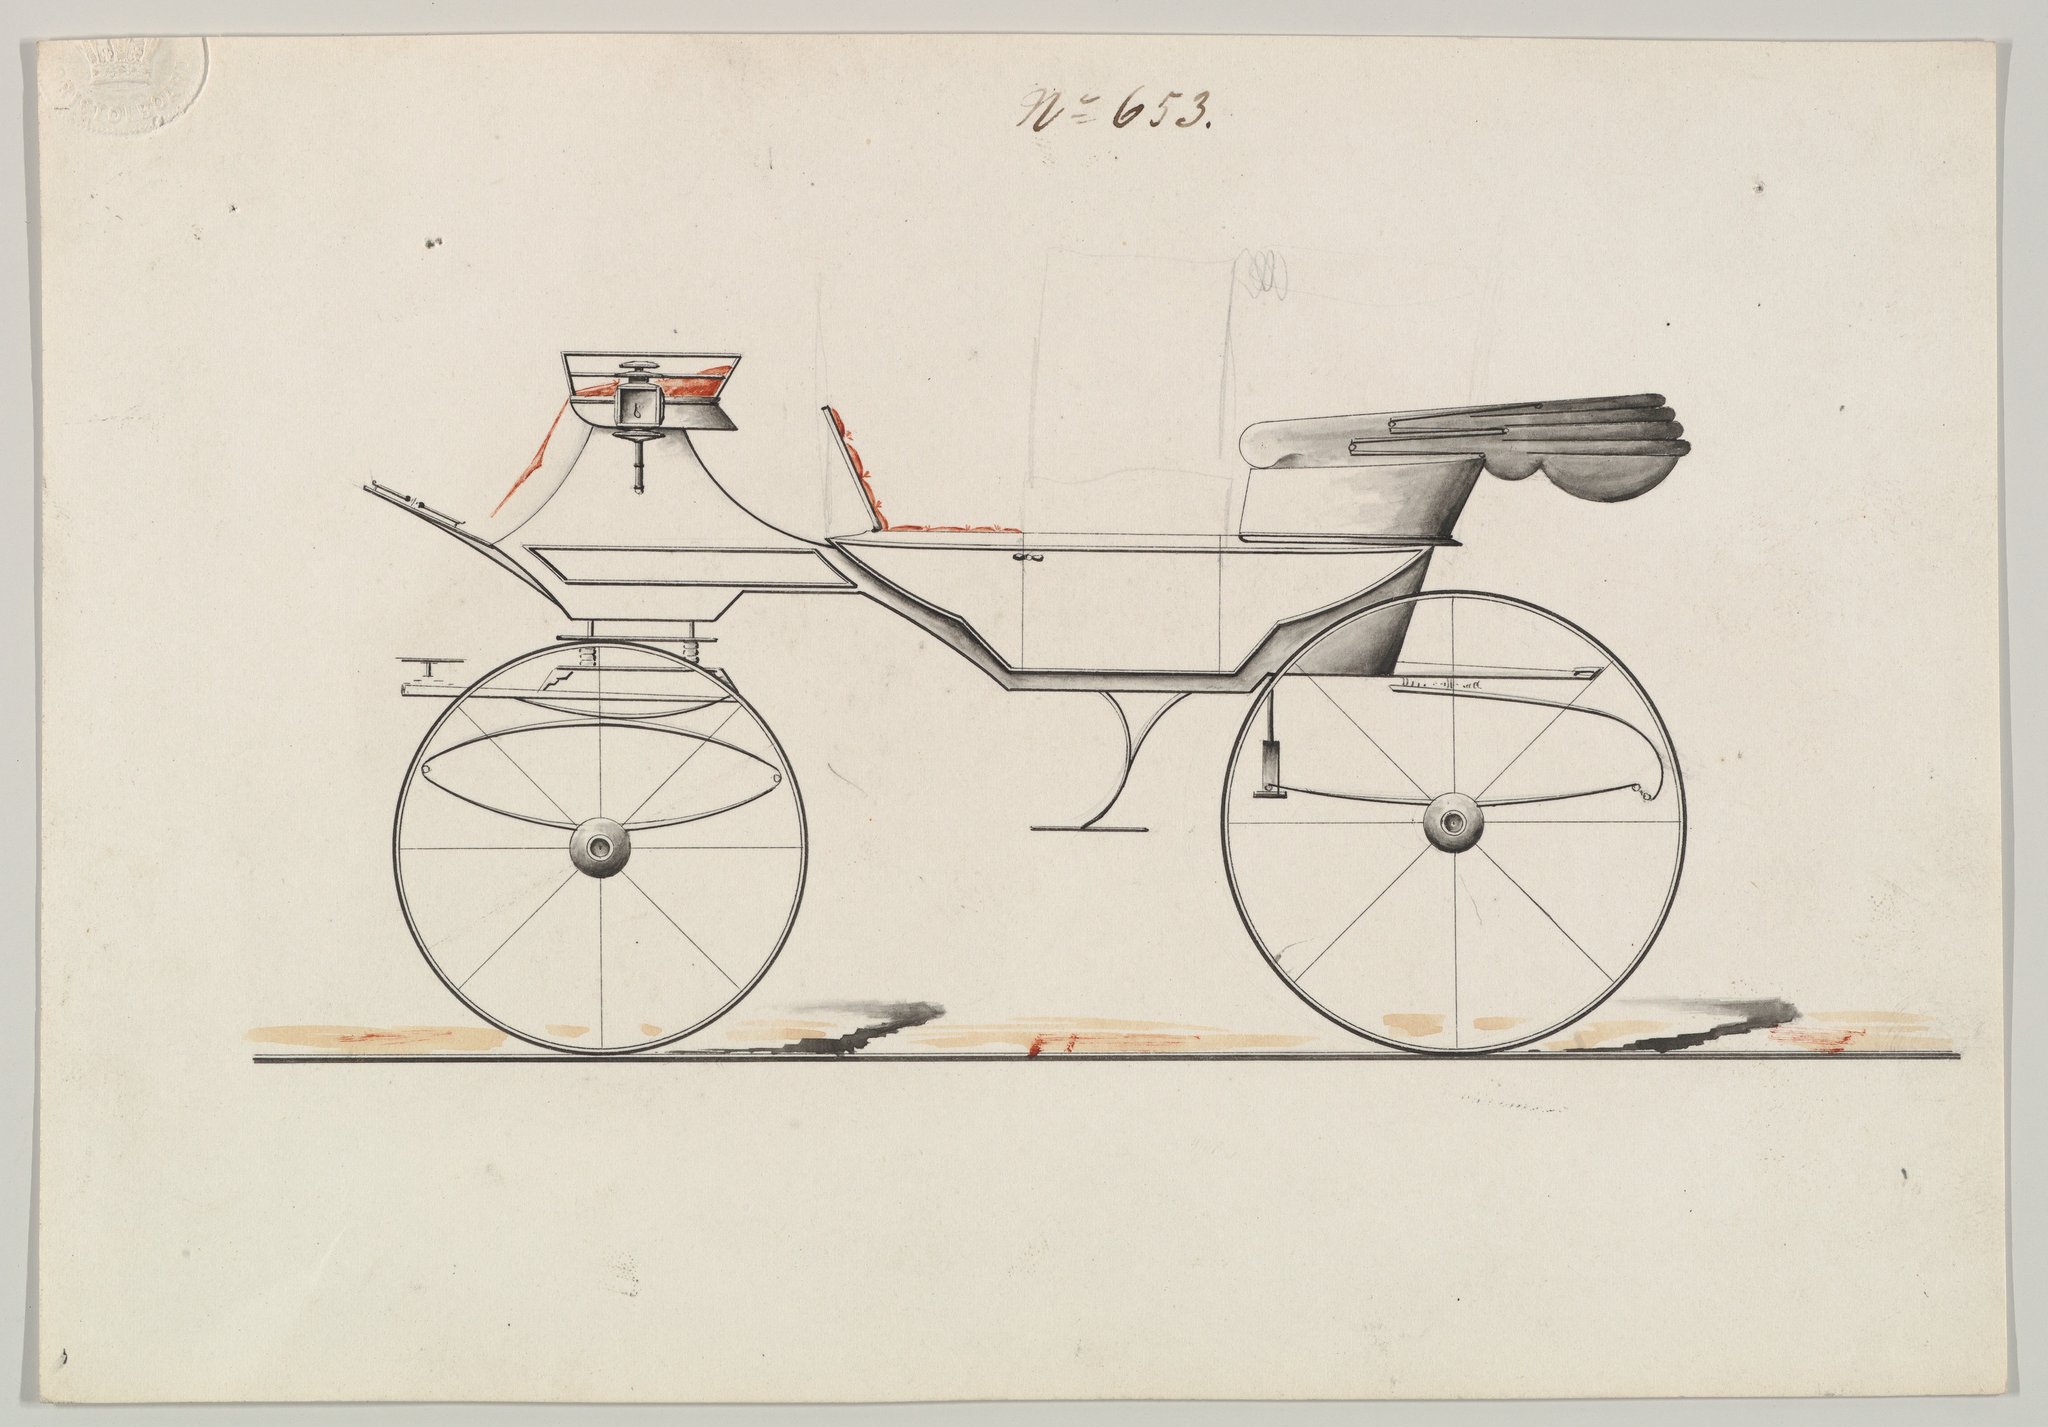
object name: drawing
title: Design for Vis-à-vis, no. 653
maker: brewster & co.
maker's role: manufacturer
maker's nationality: american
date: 1850-1870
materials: gouache, graphite, ink, watercolor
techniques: pen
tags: carriages